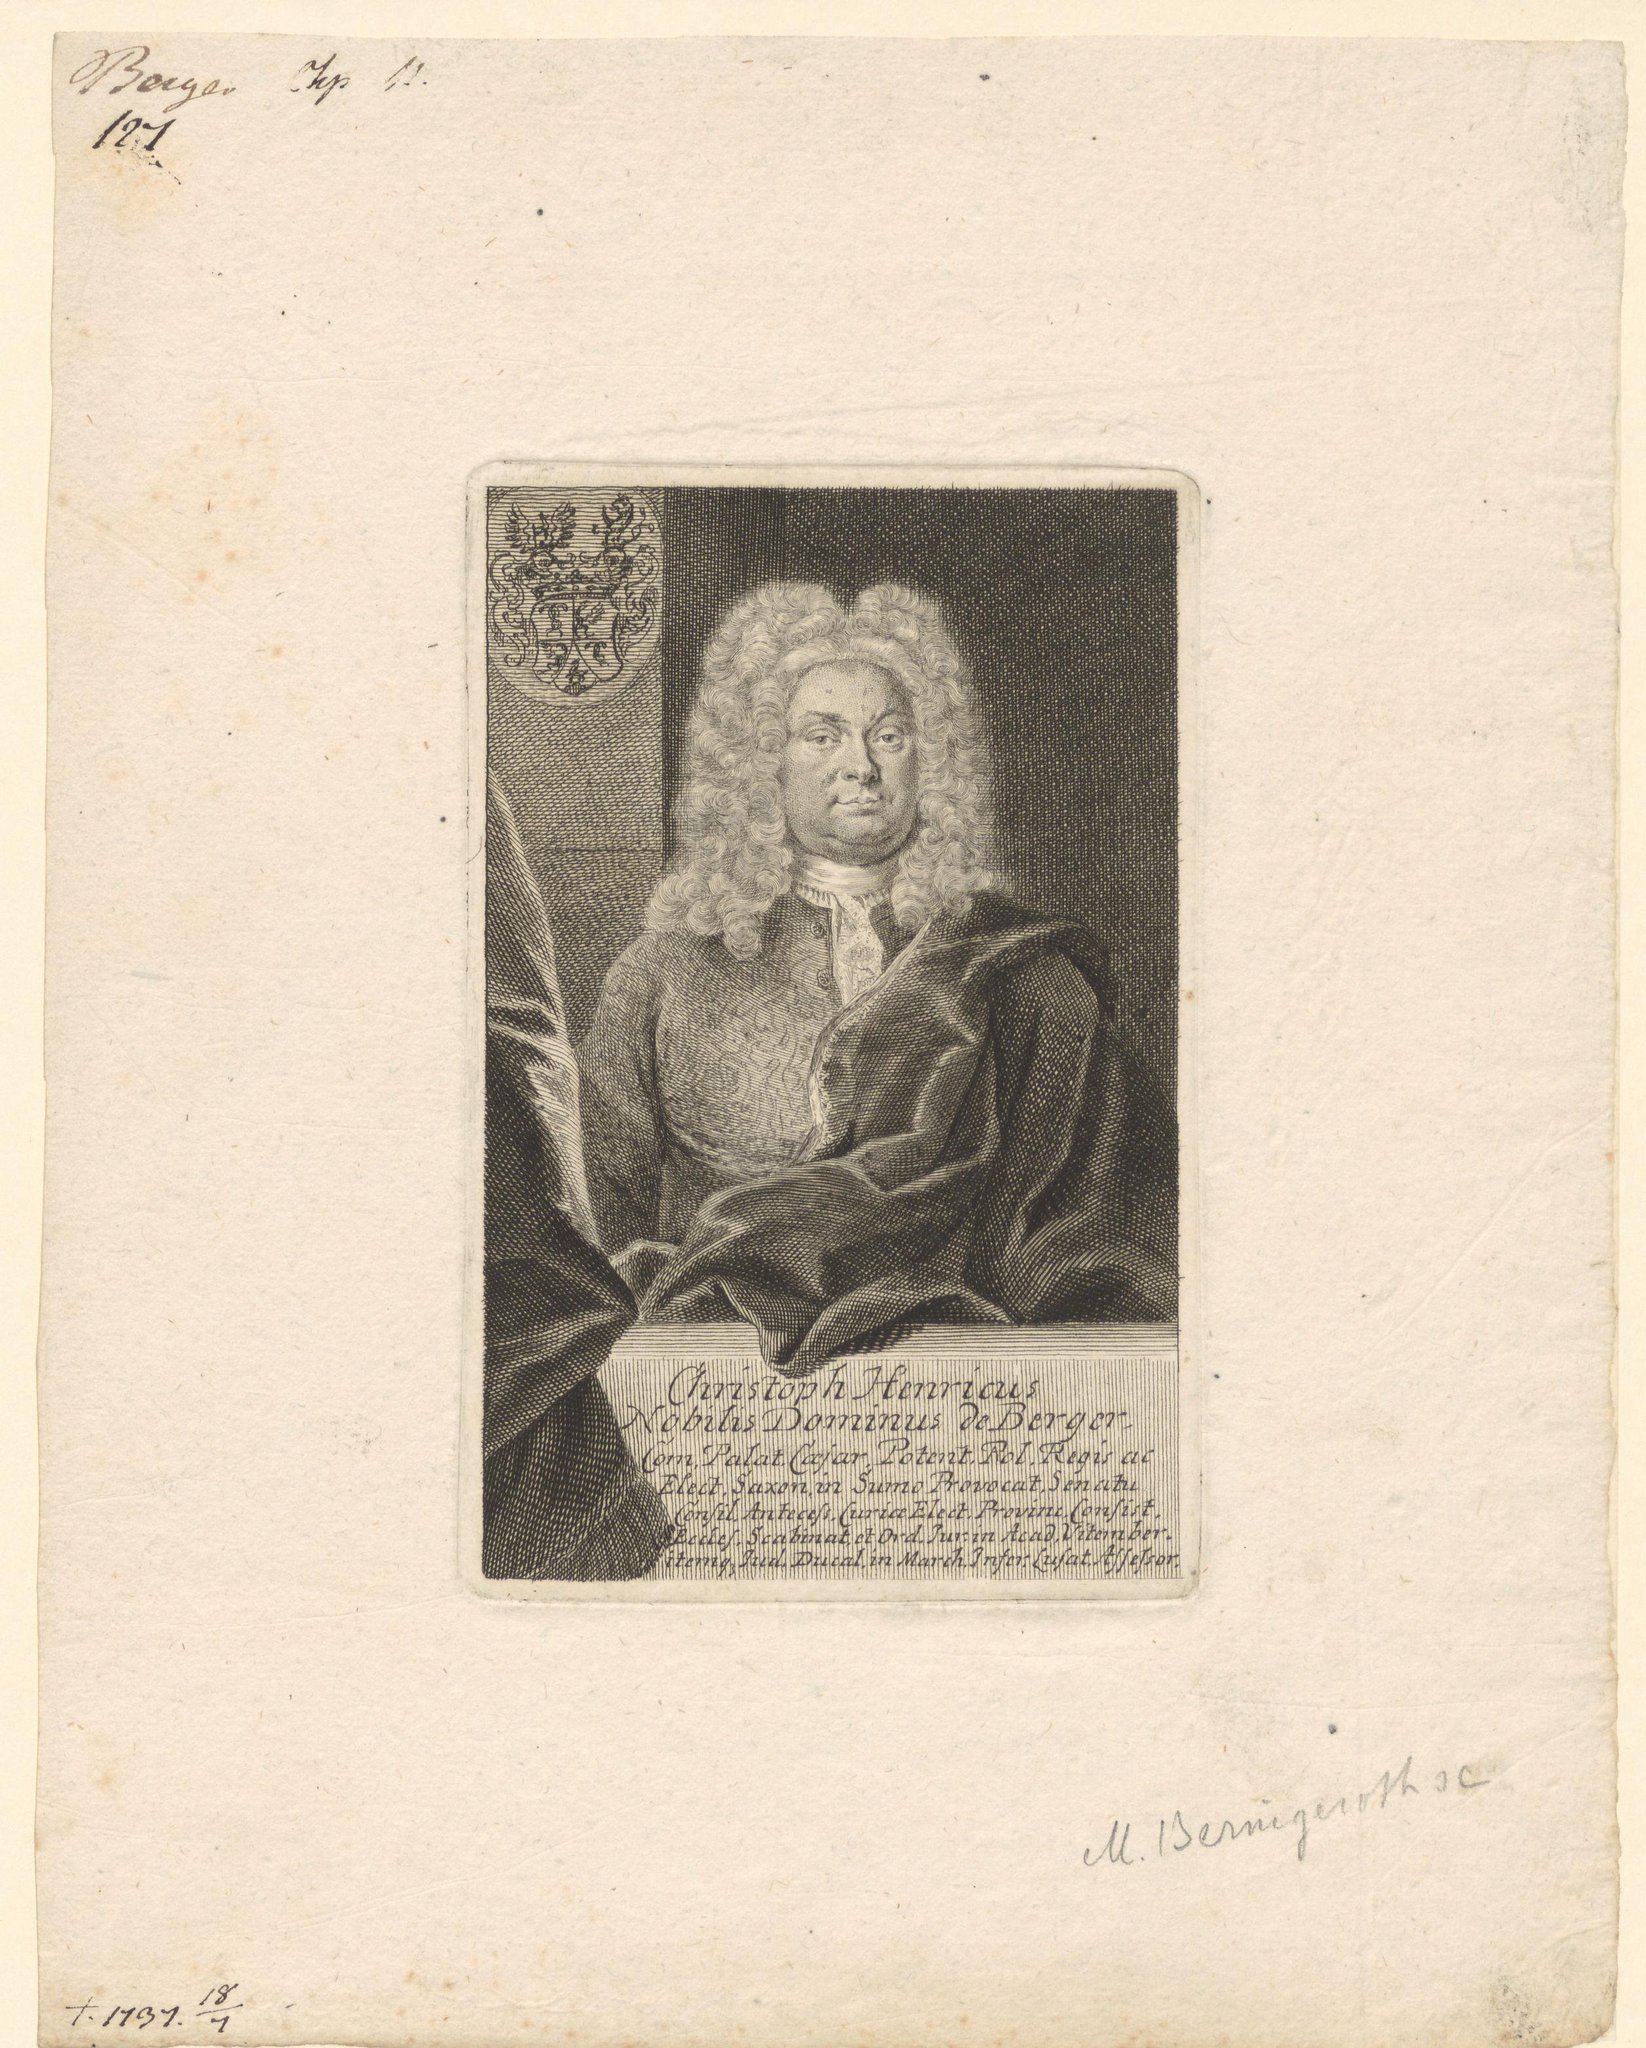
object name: print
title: Portret van Christoph Heinrich von Berger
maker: martin bernigeroth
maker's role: print maker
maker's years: 1670-1733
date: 1717-1733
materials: paper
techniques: engraving, etching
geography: leipzig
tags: vienna, historical persons, armorial bearing, heraldry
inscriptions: collector's mark: Lugt 2228